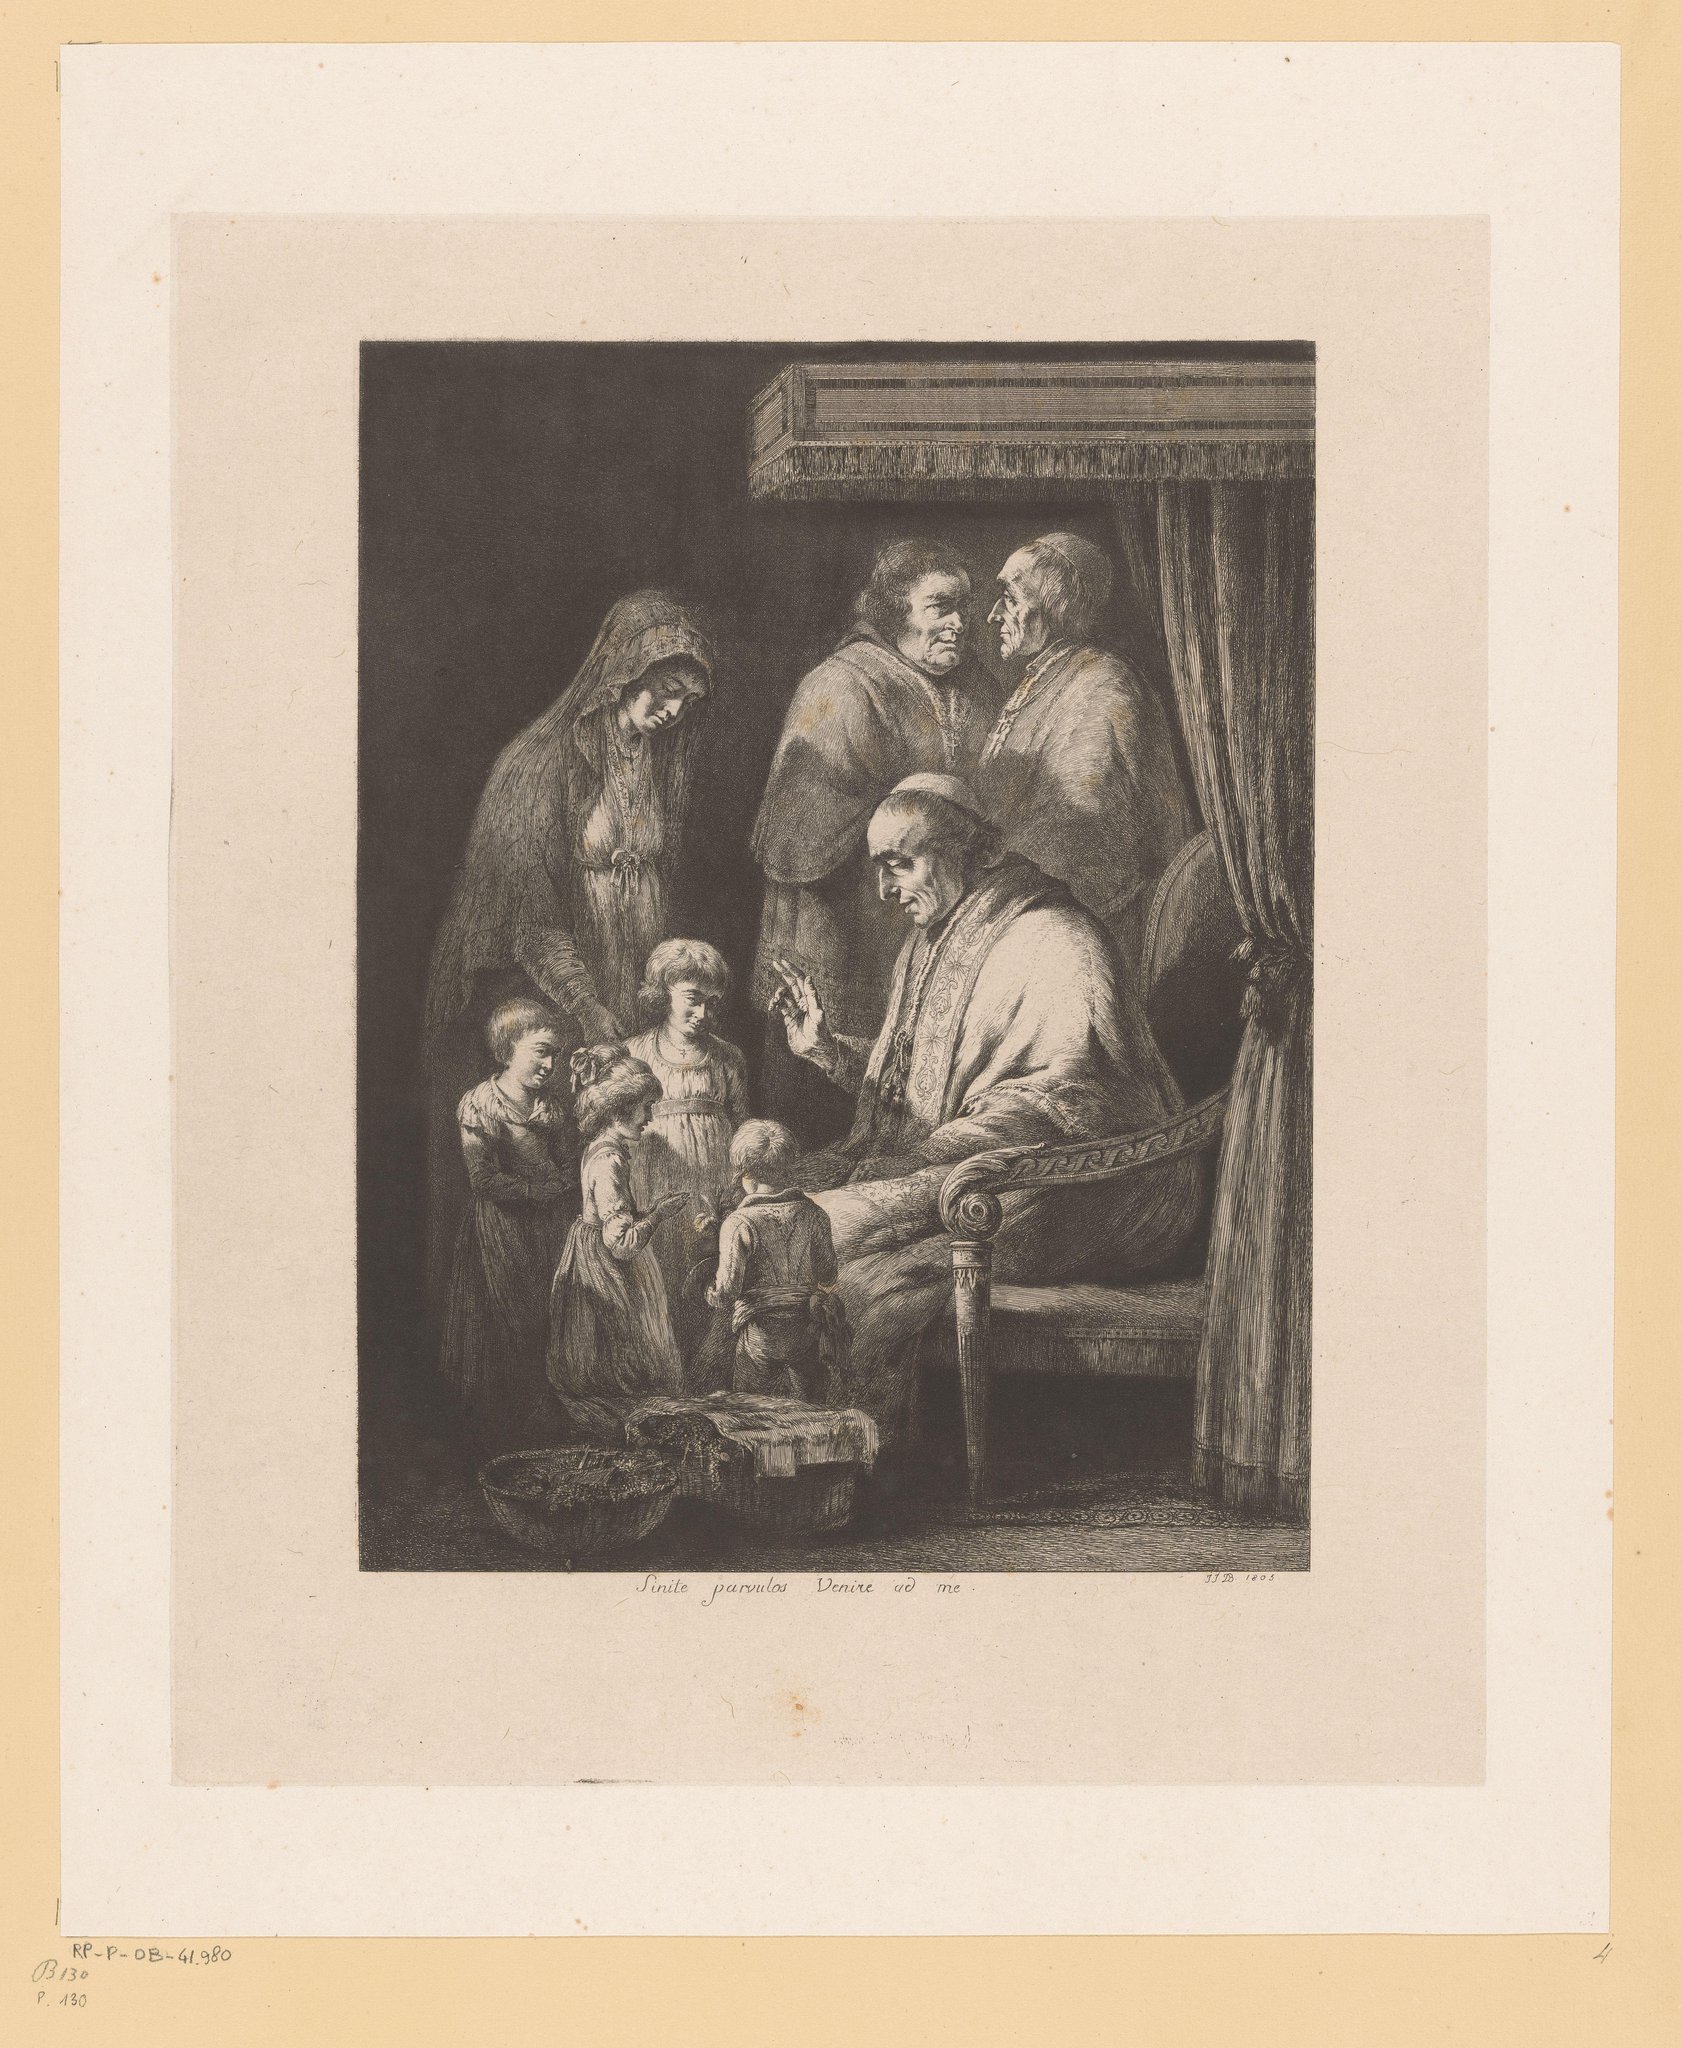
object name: print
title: Paus Pius VII zegent kinderen tijdens zijn verblijf in Lyon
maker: jean jacques de boissieu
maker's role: draughtsman, print maker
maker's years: 1736-1810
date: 1805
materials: paper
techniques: drypoint, etching, roulette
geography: france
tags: rome, clergyman, pius vii, historical persons, pope, lyon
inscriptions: collector's mark: Lugt 12